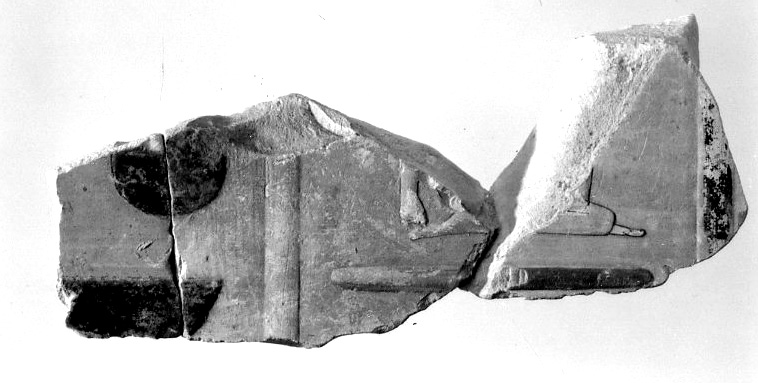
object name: relief fragment, tomb of meketre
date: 1981-1975 BCE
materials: limestone, paint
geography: egypt